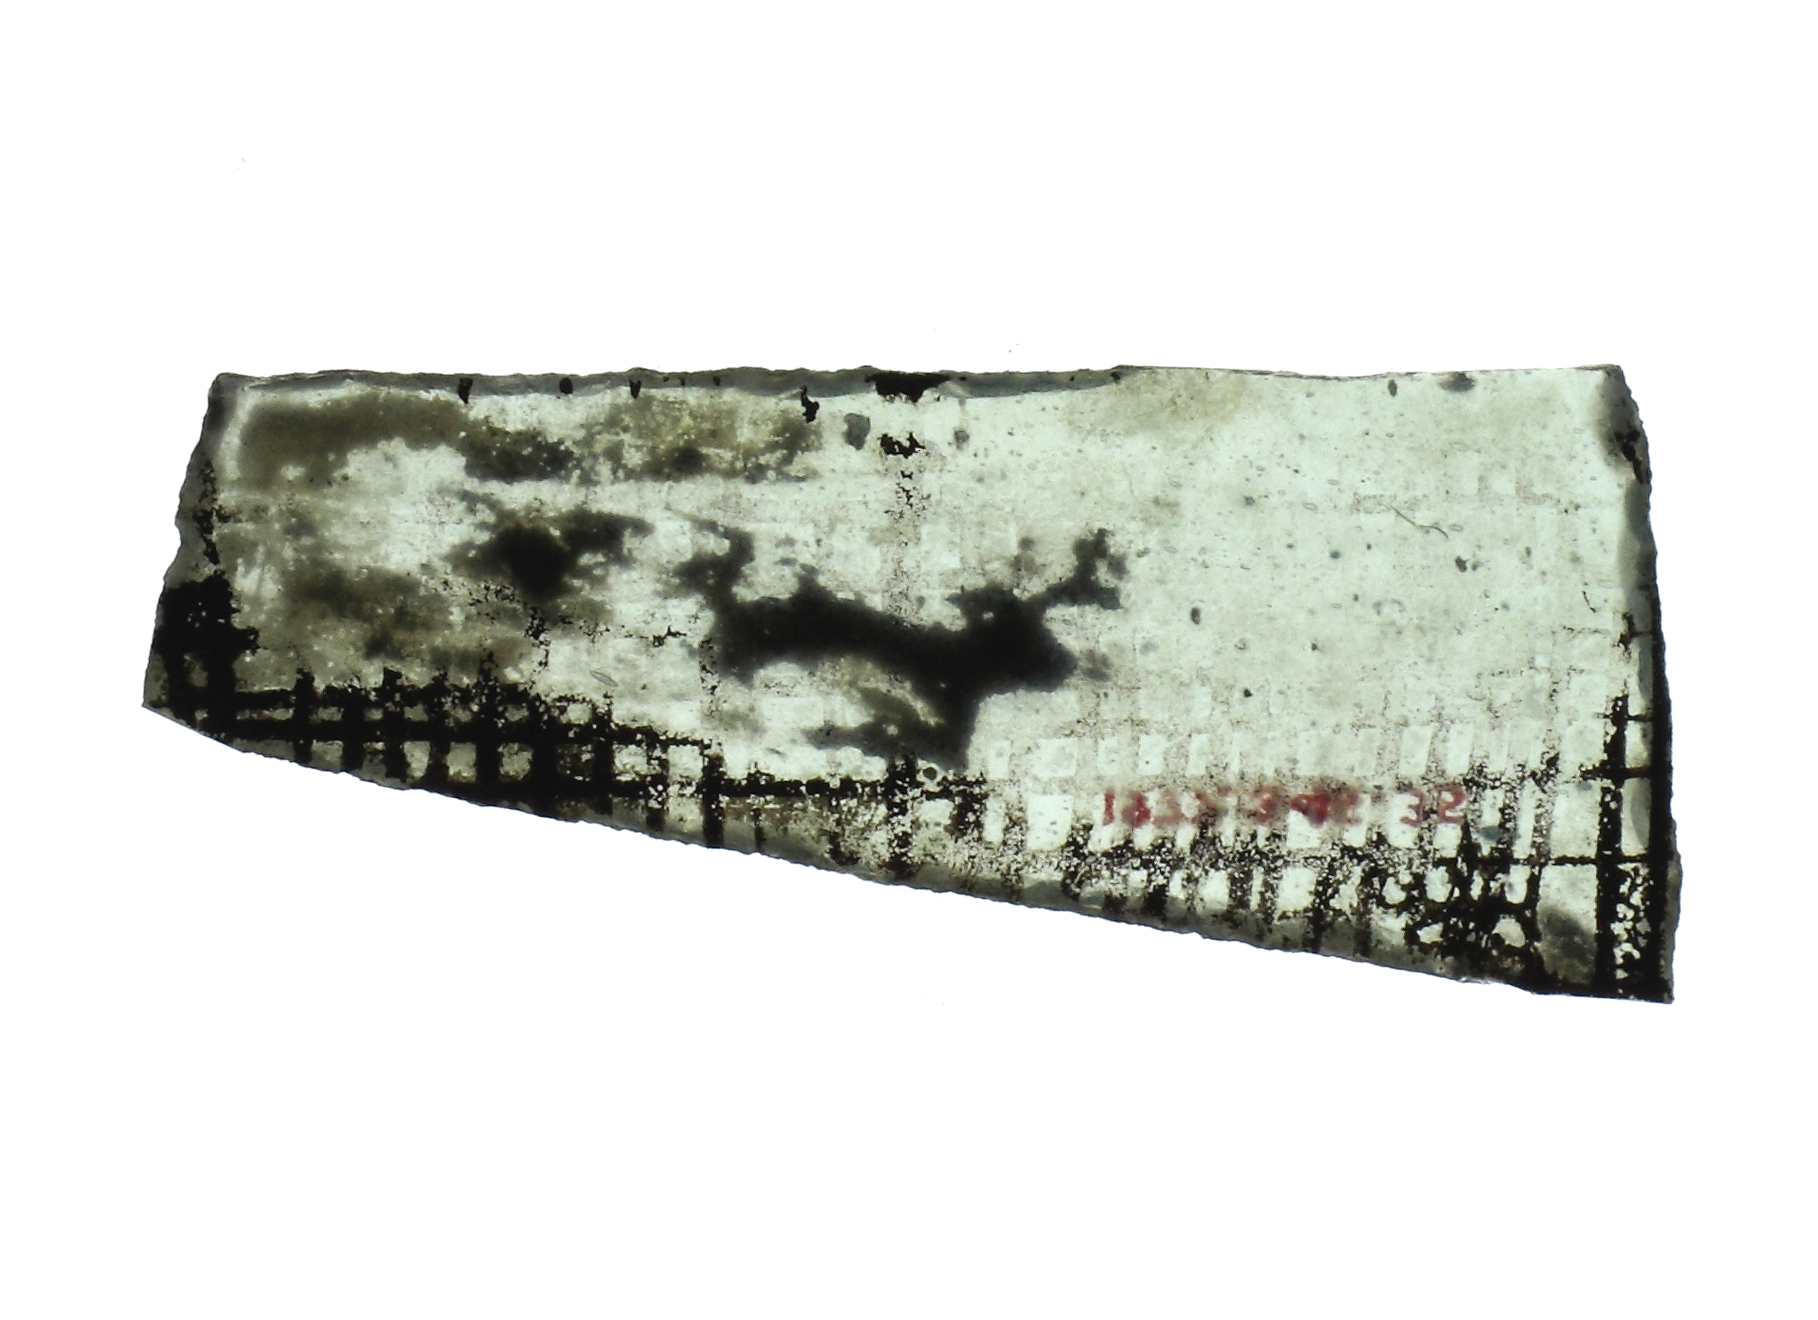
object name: fragment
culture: french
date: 1101-1400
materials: glass, metal, paint